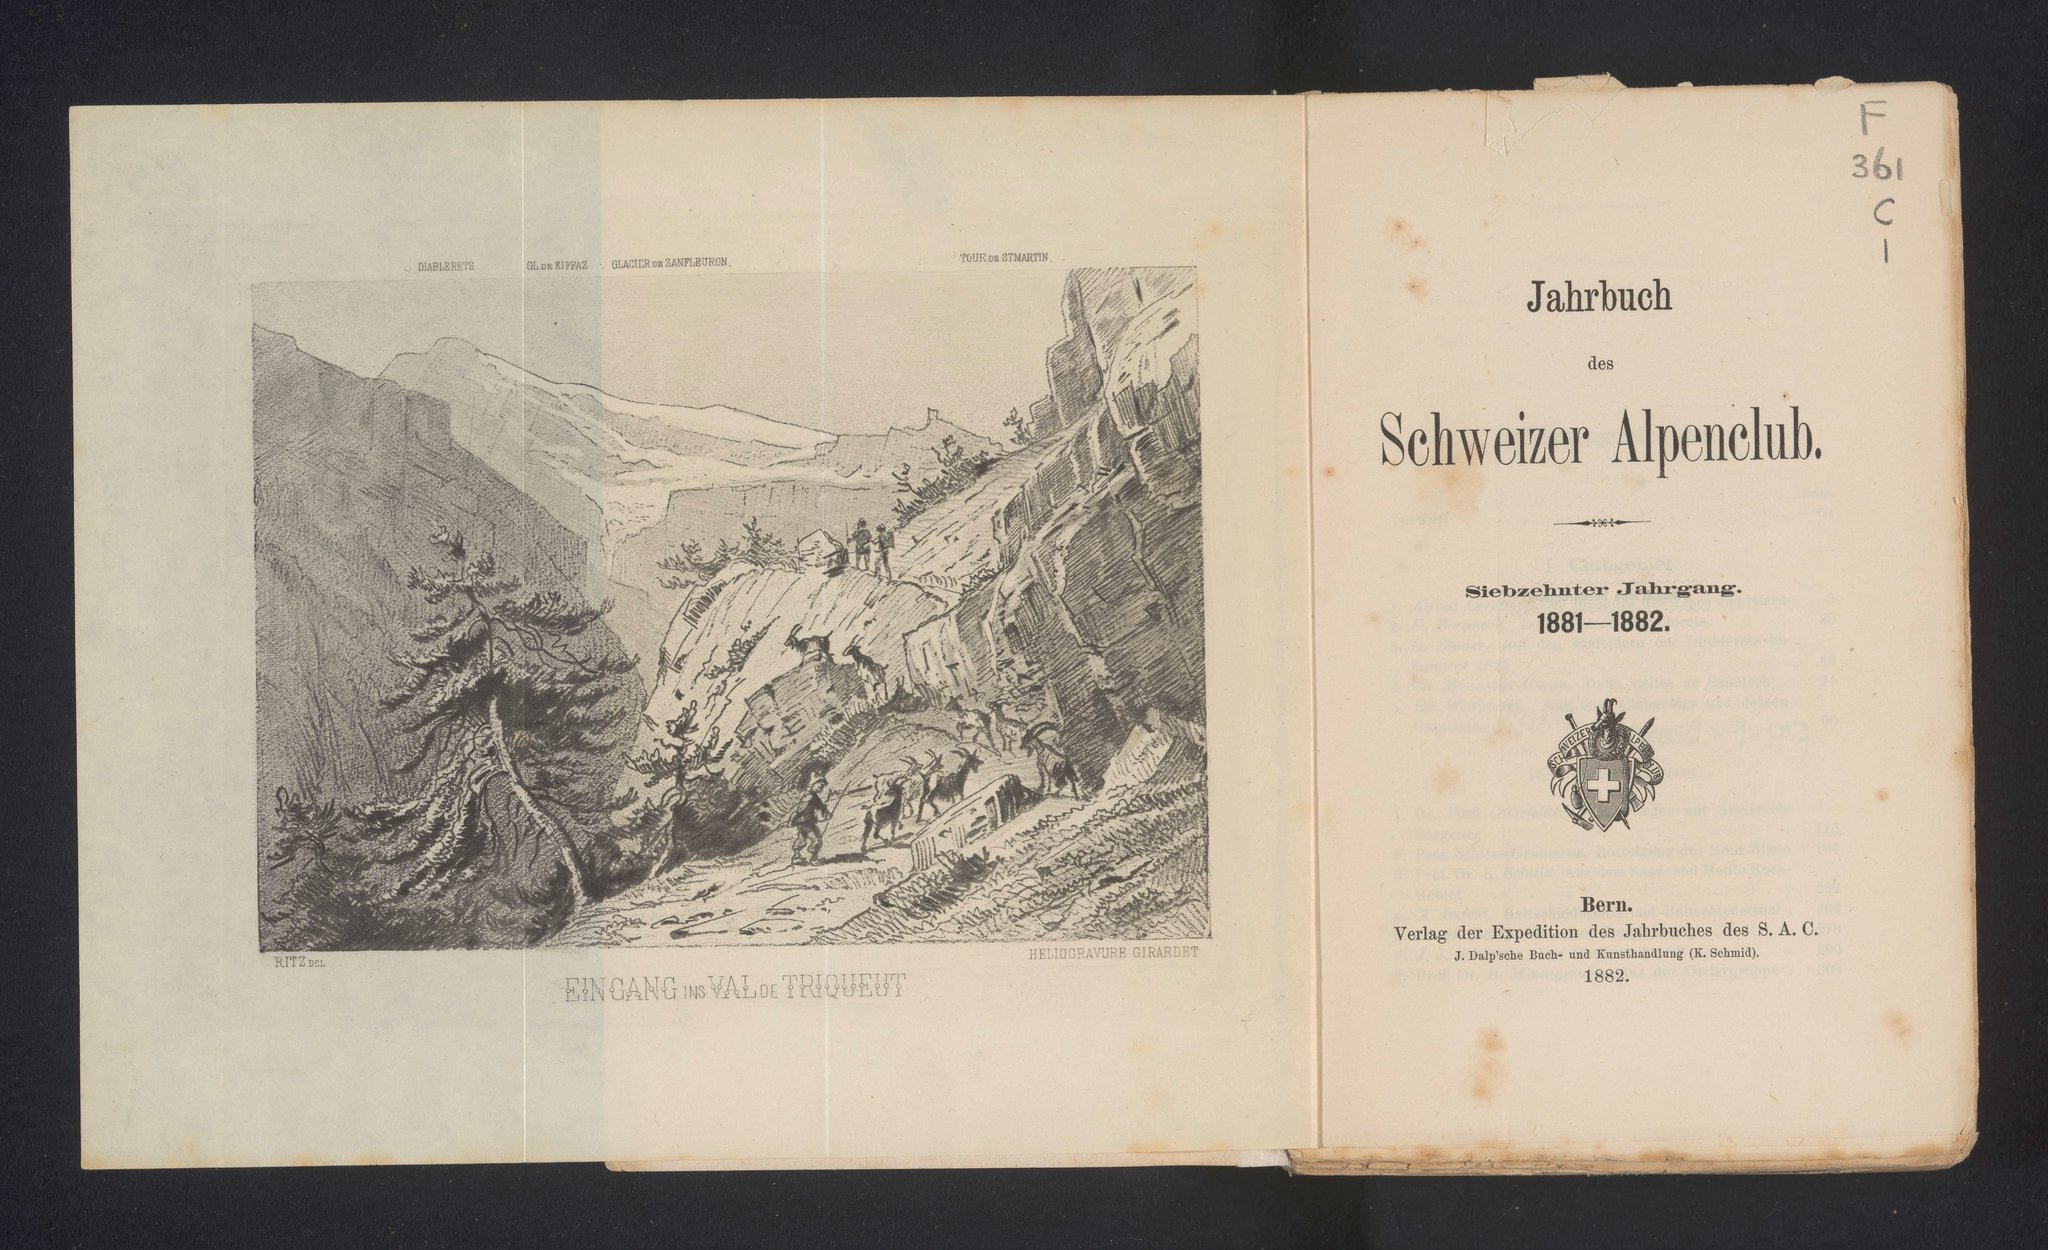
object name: book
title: Jahrbuch des Schweizer Alpenclub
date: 1882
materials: paper, photographic support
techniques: gelatin silver print, photoaquatint, printing, printing block, engraving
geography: bern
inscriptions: annotation: ‘4202/../91’, date: ‘JULY 1996’